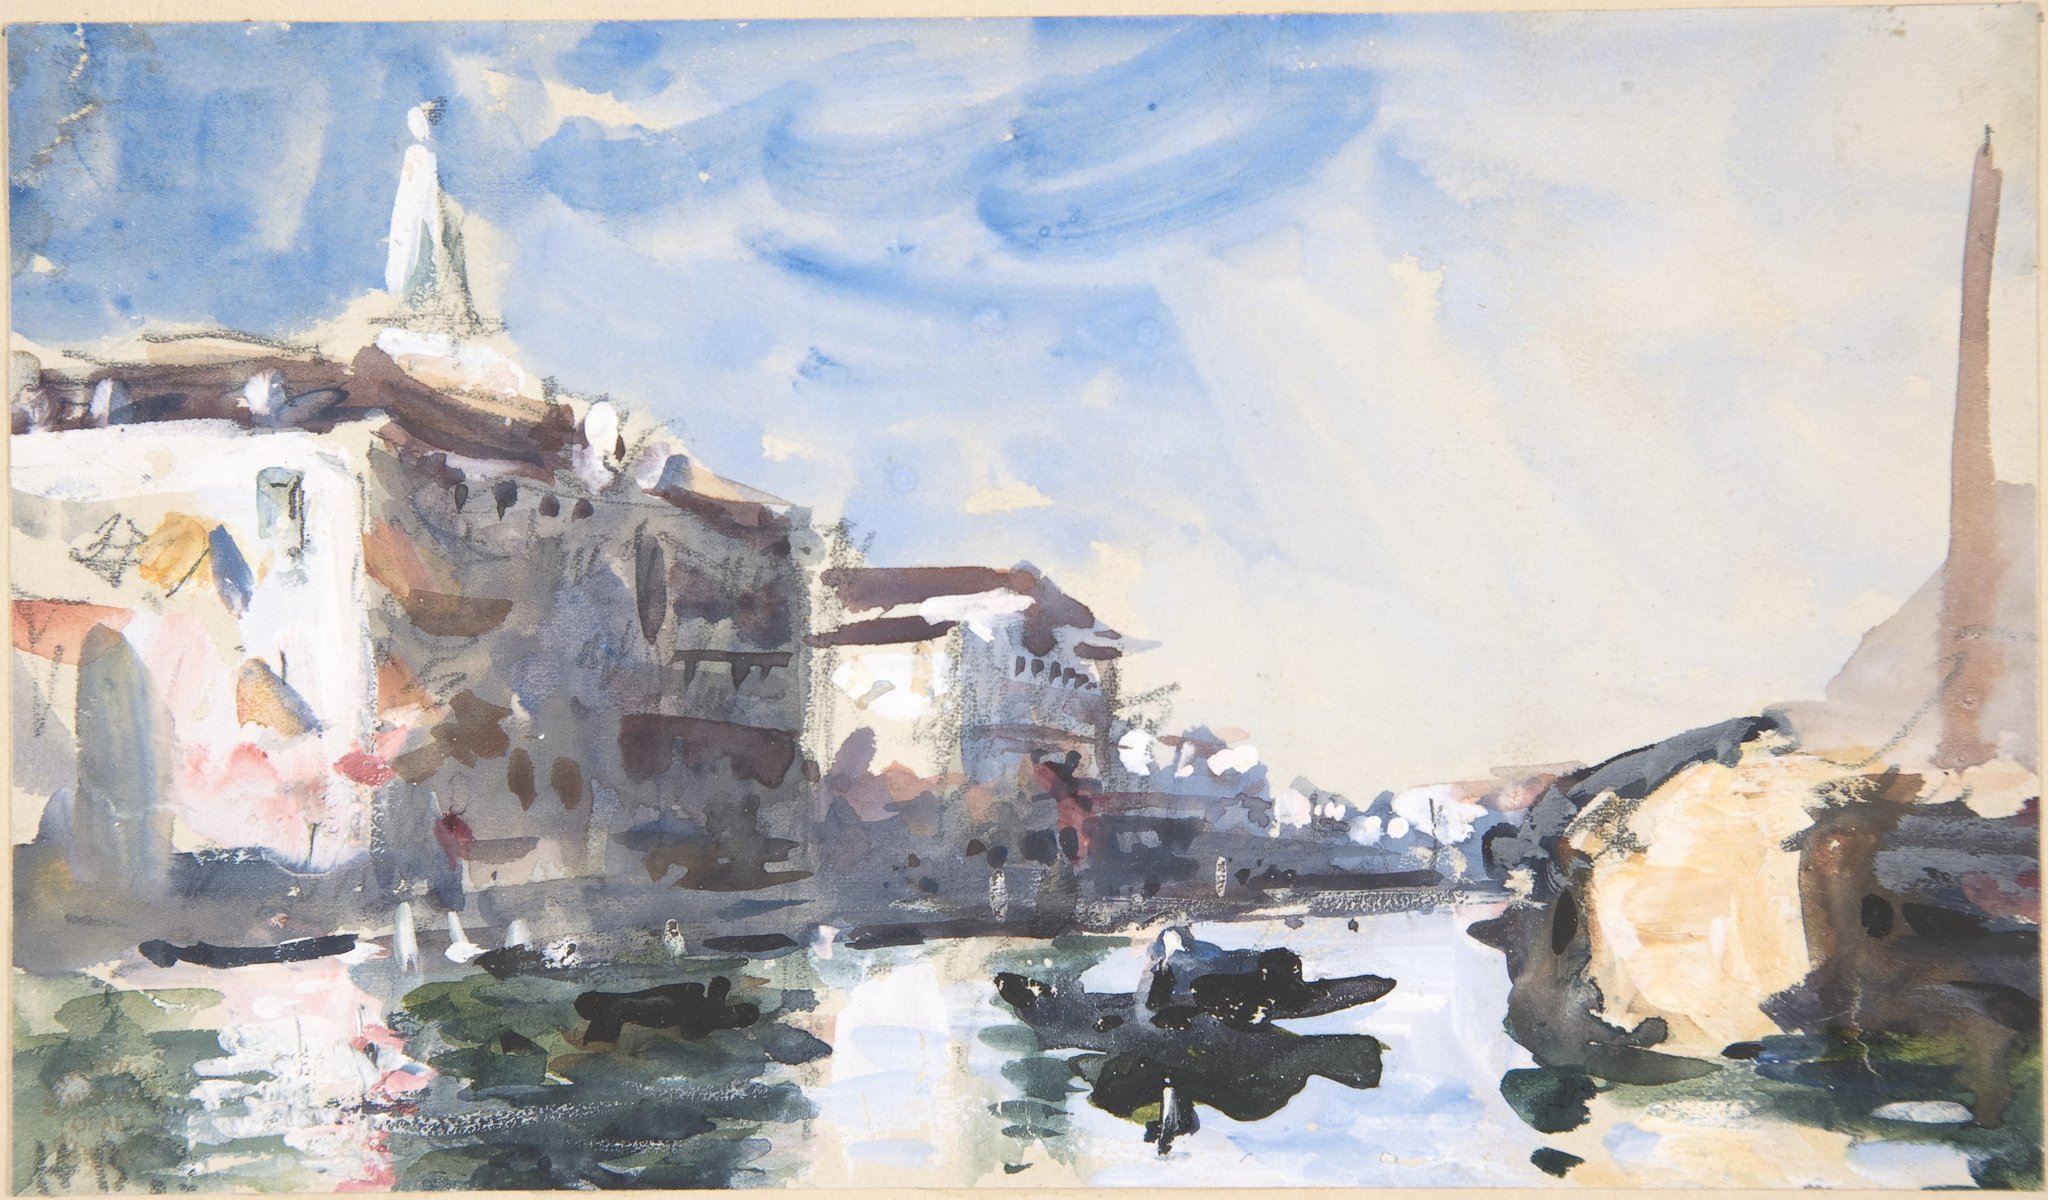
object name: drawing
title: Scene on the Grand Canal, Venice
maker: hercules brabazon brabazon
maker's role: artist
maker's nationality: british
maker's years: 1821-1906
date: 1801-1900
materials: gouache, graphite, watercolor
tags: houses,canals,boats,venice